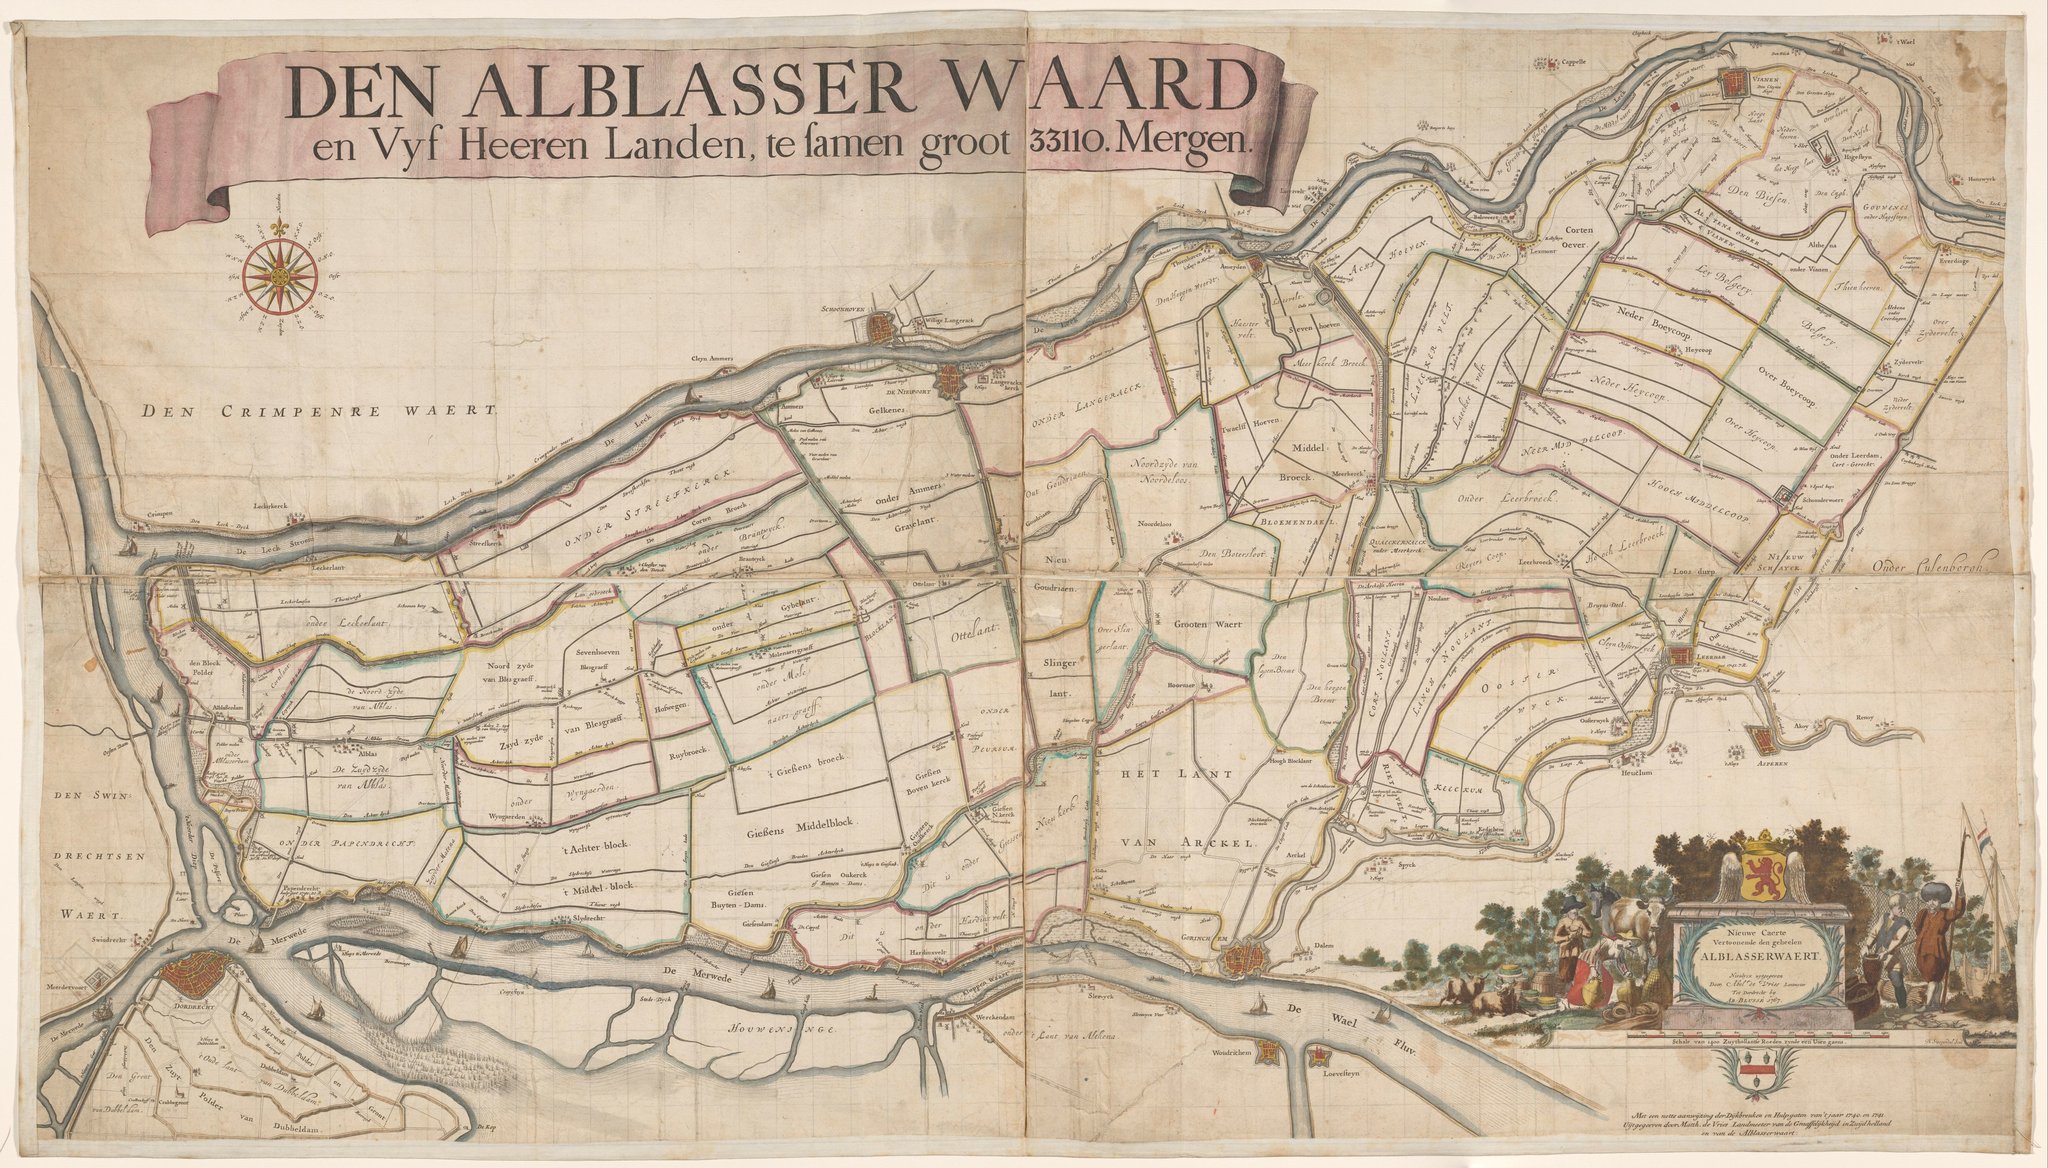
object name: print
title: Den Alblasser Waard en Vyf Heeren Landen, te samen groot 33110. mergen / Nieuwe caerte vertoonende den geheelen Alblasserwaert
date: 1681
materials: linen, paper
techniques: engraving, etching, hand coloring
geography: amsterdam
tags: commercial fishery, coat of arms (as symbol of the state, etc.), sailing-ship, sailing-boat, maps of separate countries or regions, cattle, farmers, agriculture, polder, reclaimed land, milkmaid, fisherman, cheese, armorial bearing, heraldry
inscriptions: collector's mark: Lugt 19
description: Langs de bovenkant een banderol met de eerste titel. Rechtsonder een cartouche met de tweede titel en daarboven het wapen van de Alblasserwaard. Links van de cartouche een landbouwer, een vrouwfiguur met een melkjuk, vee en voorwerpen die verwijzen naar de landbouw. Rechts van de cartouche een visser met een visnet, een visser met een enterhaak, een vissersboot en andere voorwerpen die verwijzen naar de visserij. Onder de cartouche een schaalstok: Schale van 1400 Zuythollantse roeden, zynde een uure gaens. Daaronder een wapenschild met drie eikels en een dwarsbalk (vermoedelijk het wapen van landmeters Abel en Matthijs (I) de Vries).